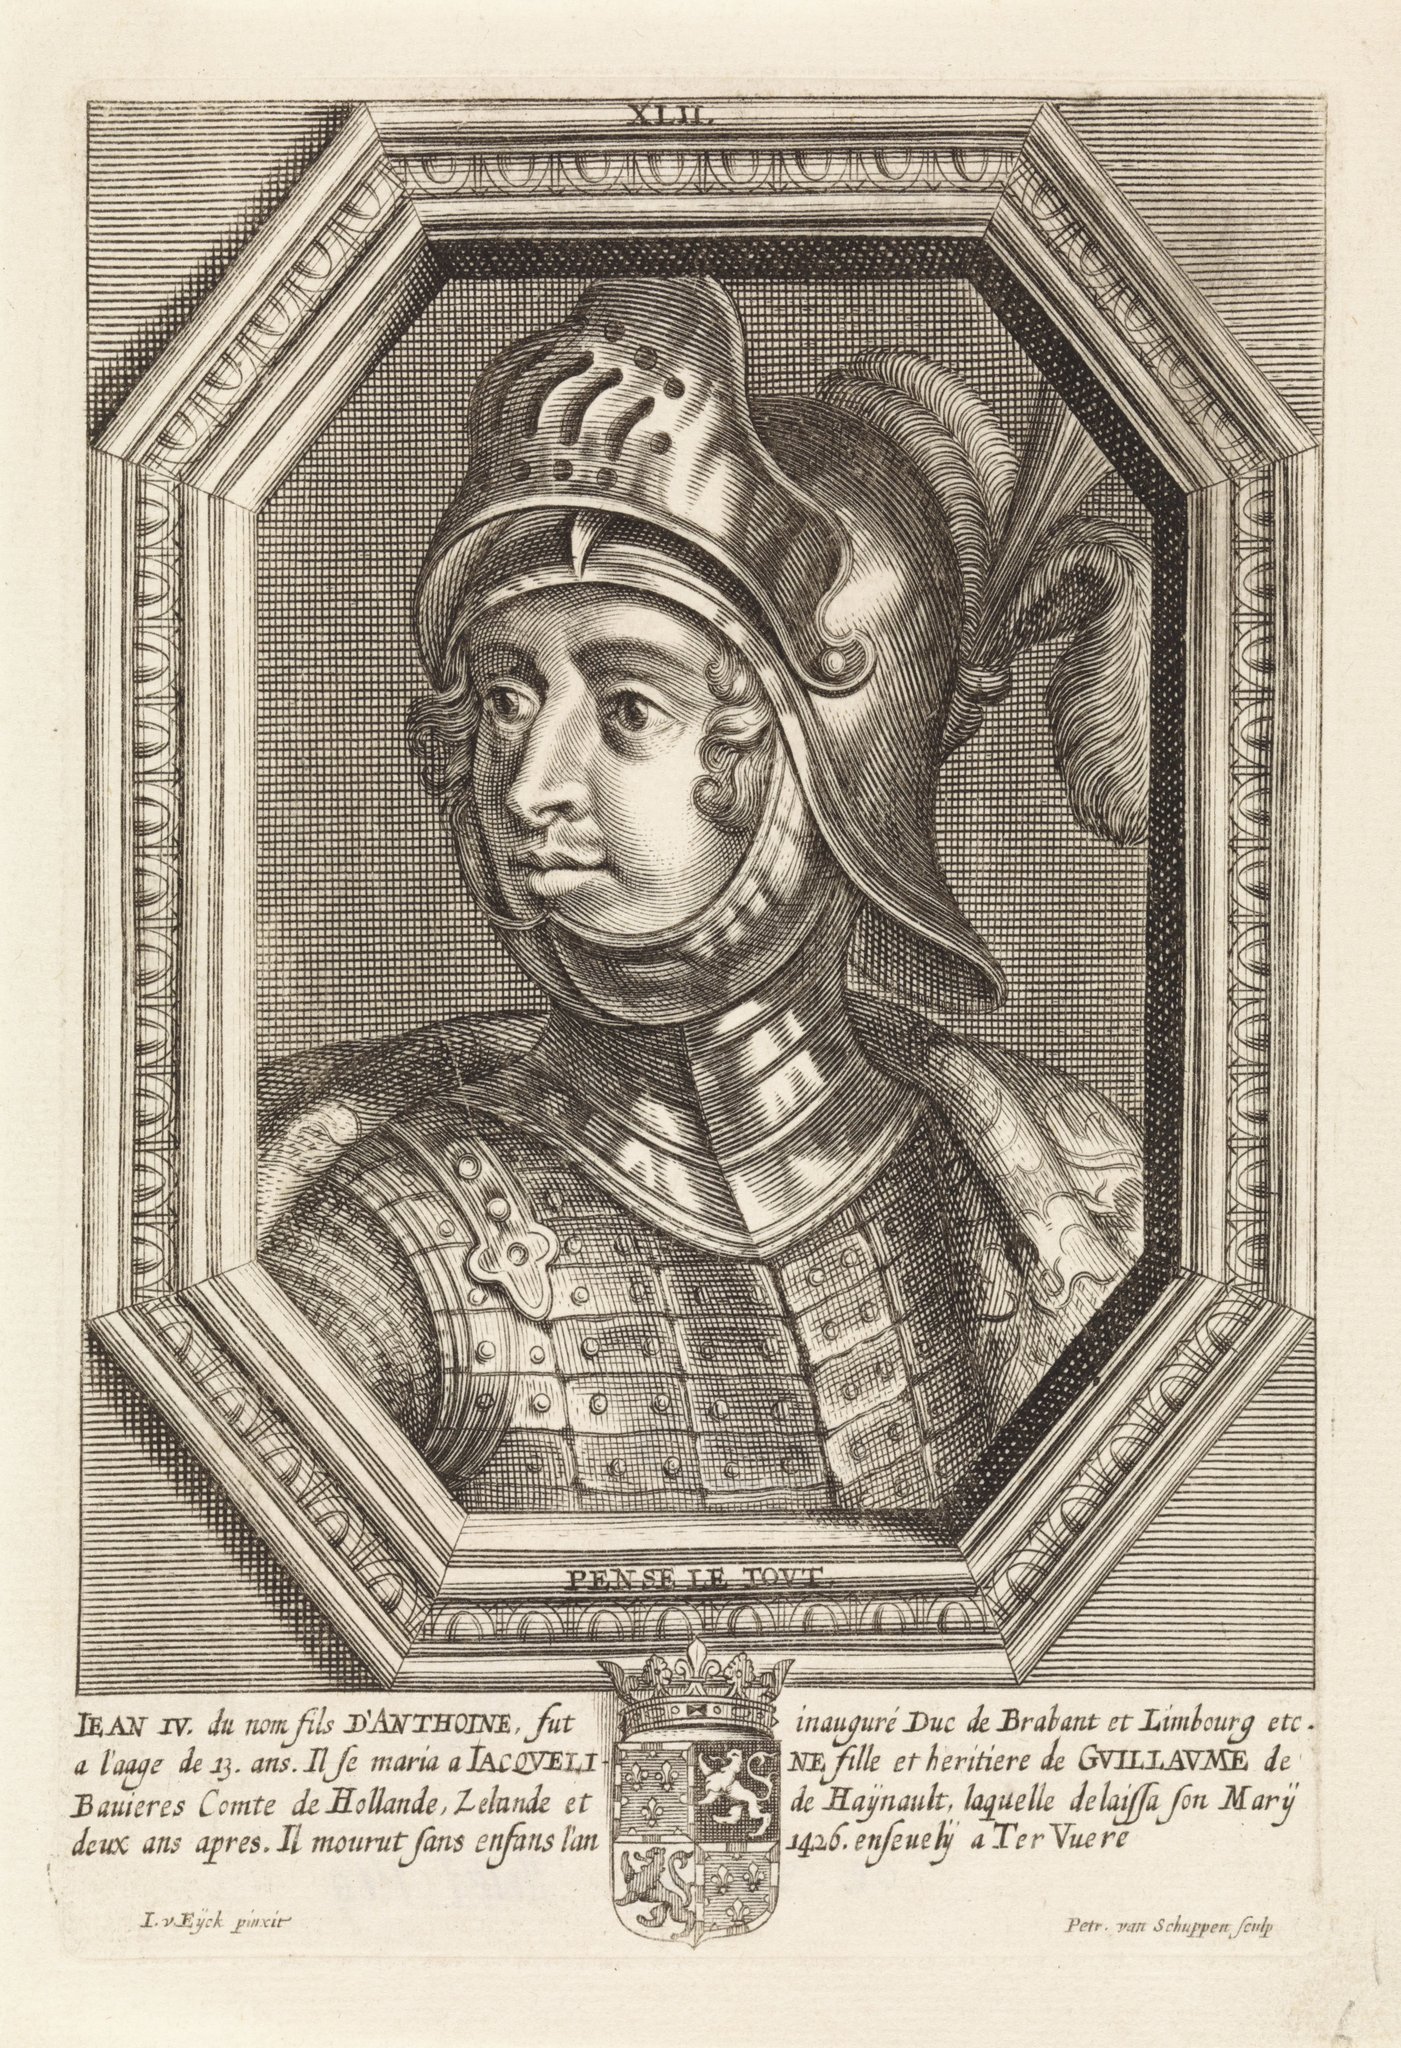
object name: book illustration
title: Portret van Jan IV, hertog van Brabant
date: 1660-1669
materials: paper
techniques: engraving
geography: paris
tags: brussels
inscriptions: collector's mark: Lugt 2228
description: Portret van Jan IV, hertog van Brabant, met spreuk en wapenschild. Onder het portret een korte levensbeschrijving. Bovenaan genummerd 'XLII'.